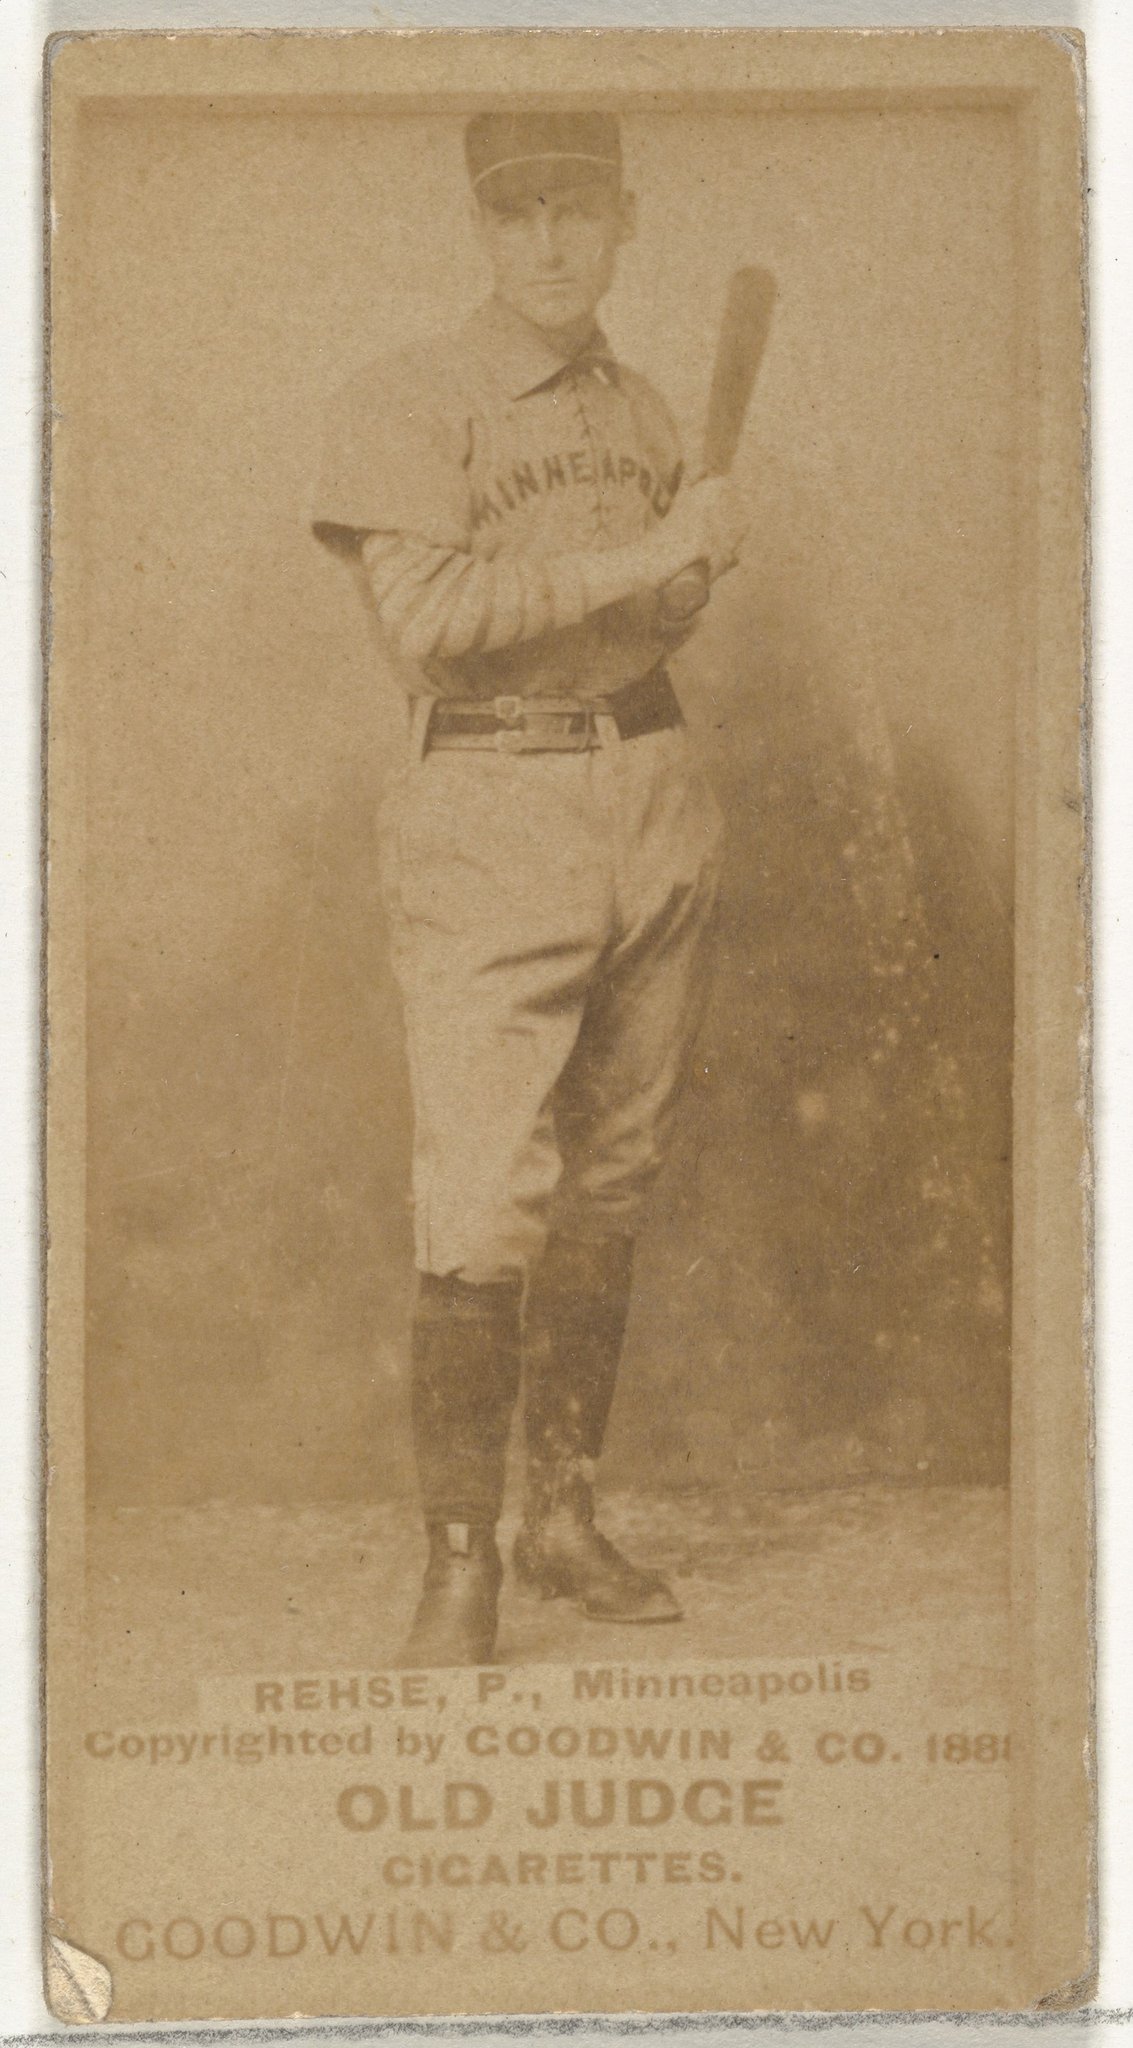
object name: baseball card, photograph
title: Rehse, Pitcher, Minneapolis, from the Old Judge series (N172) for Old Judge Cigarettes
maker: goodwin & company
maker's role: publisher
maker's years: 1850-1950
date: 1888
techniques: albumen silver print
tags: men,portraits,baseball,athletes